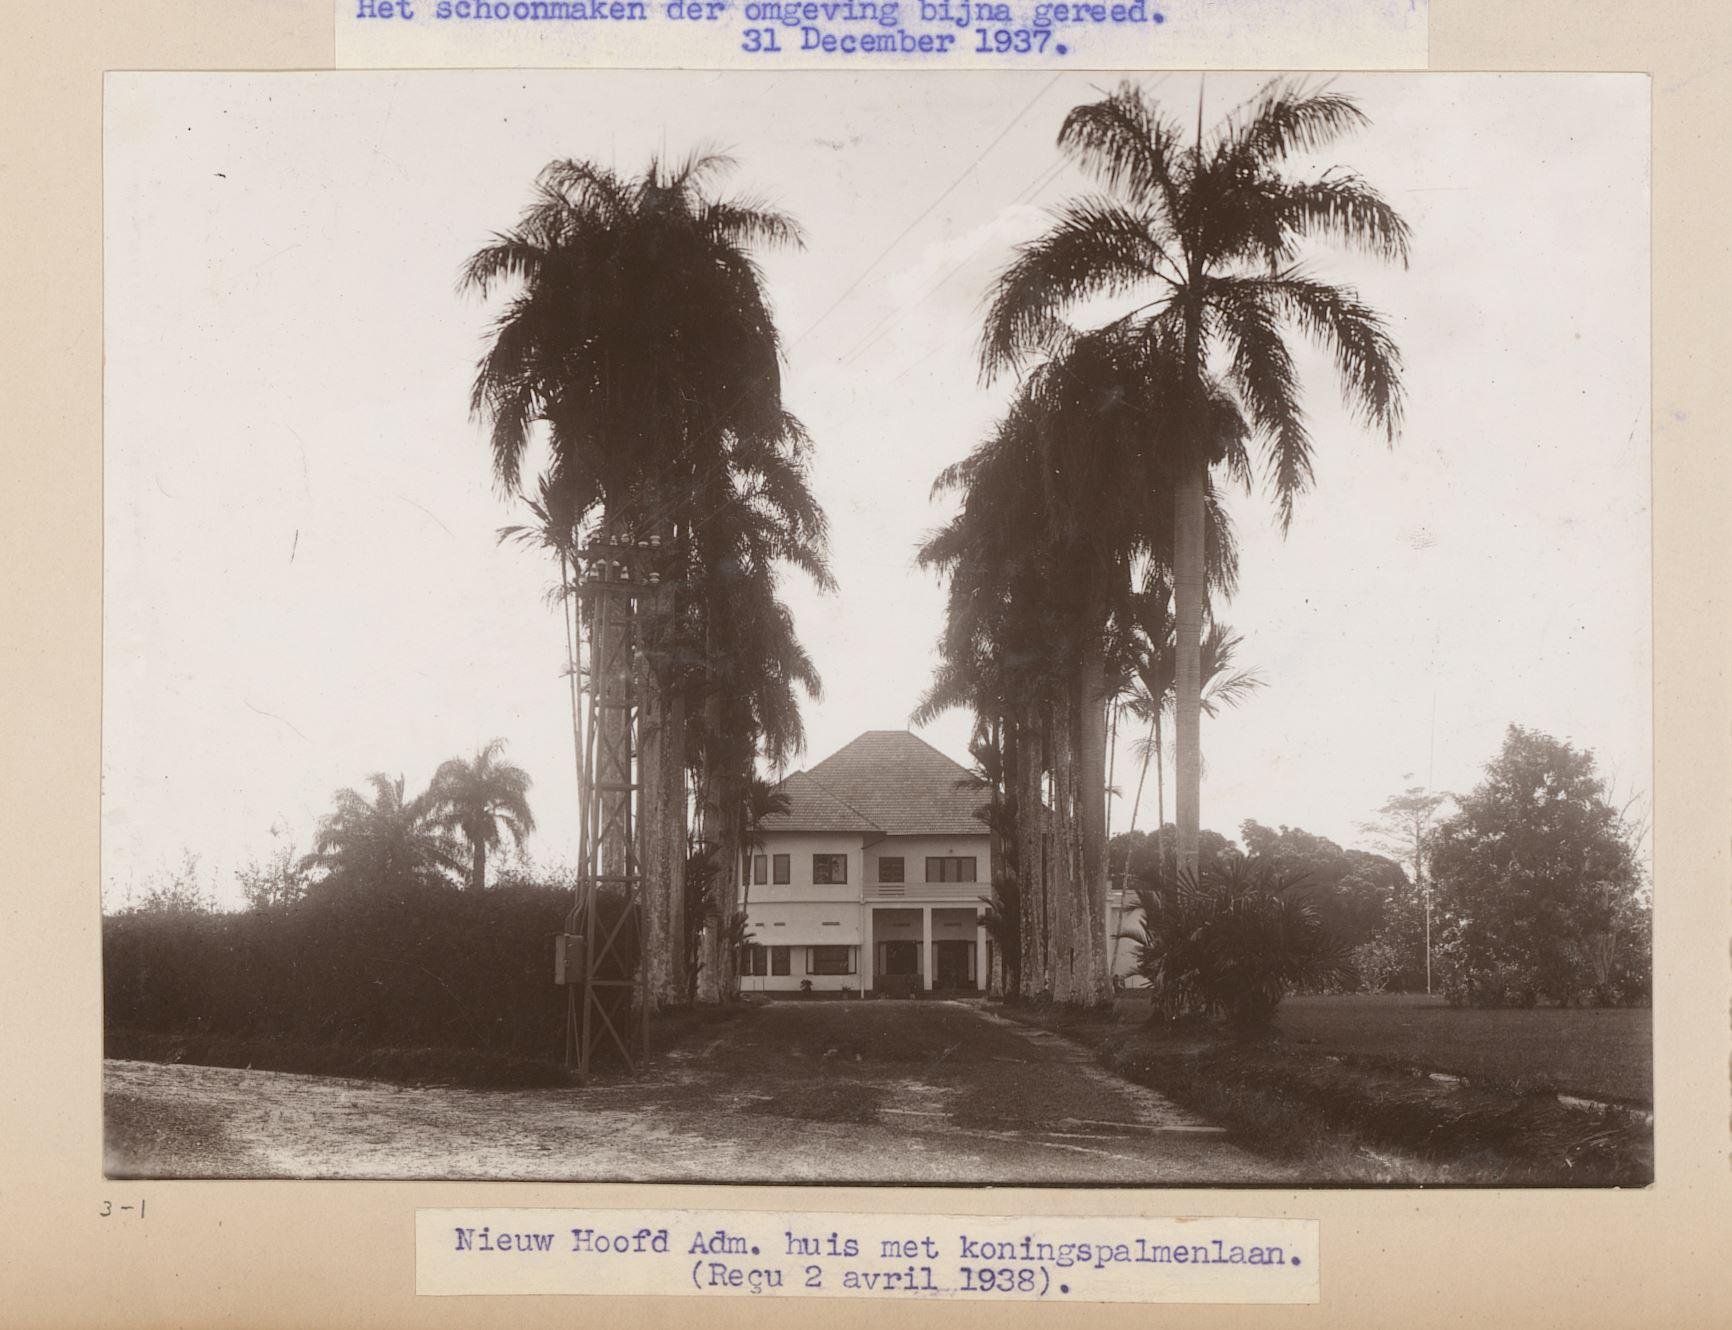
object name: photograph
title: Nieuw Hoofd Adm. huis met koningspalmenlaan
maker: Anonymous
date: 1938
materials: photographic support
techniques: collodion silver print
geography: sumatra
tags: plantation, villa, sumatra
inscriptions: inscription: ‘Nieuw Hoofd Adm. huis met koningspalmenlaan. (Reçu 2 avril 1938)’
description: De nieuwe woning voor de hoofdadministrateur op de plantage Brussel, gezien door de oprit met aan weerszijden koningspalmen, opgeleverd op 31 december 1937. Onderdeel van het fotoalbum over de plantages Pernantian en Brussel van de Sumatra Caoutchouc Maatschappij op de Oostkust van Sumatra in de jaren 1935-1939.